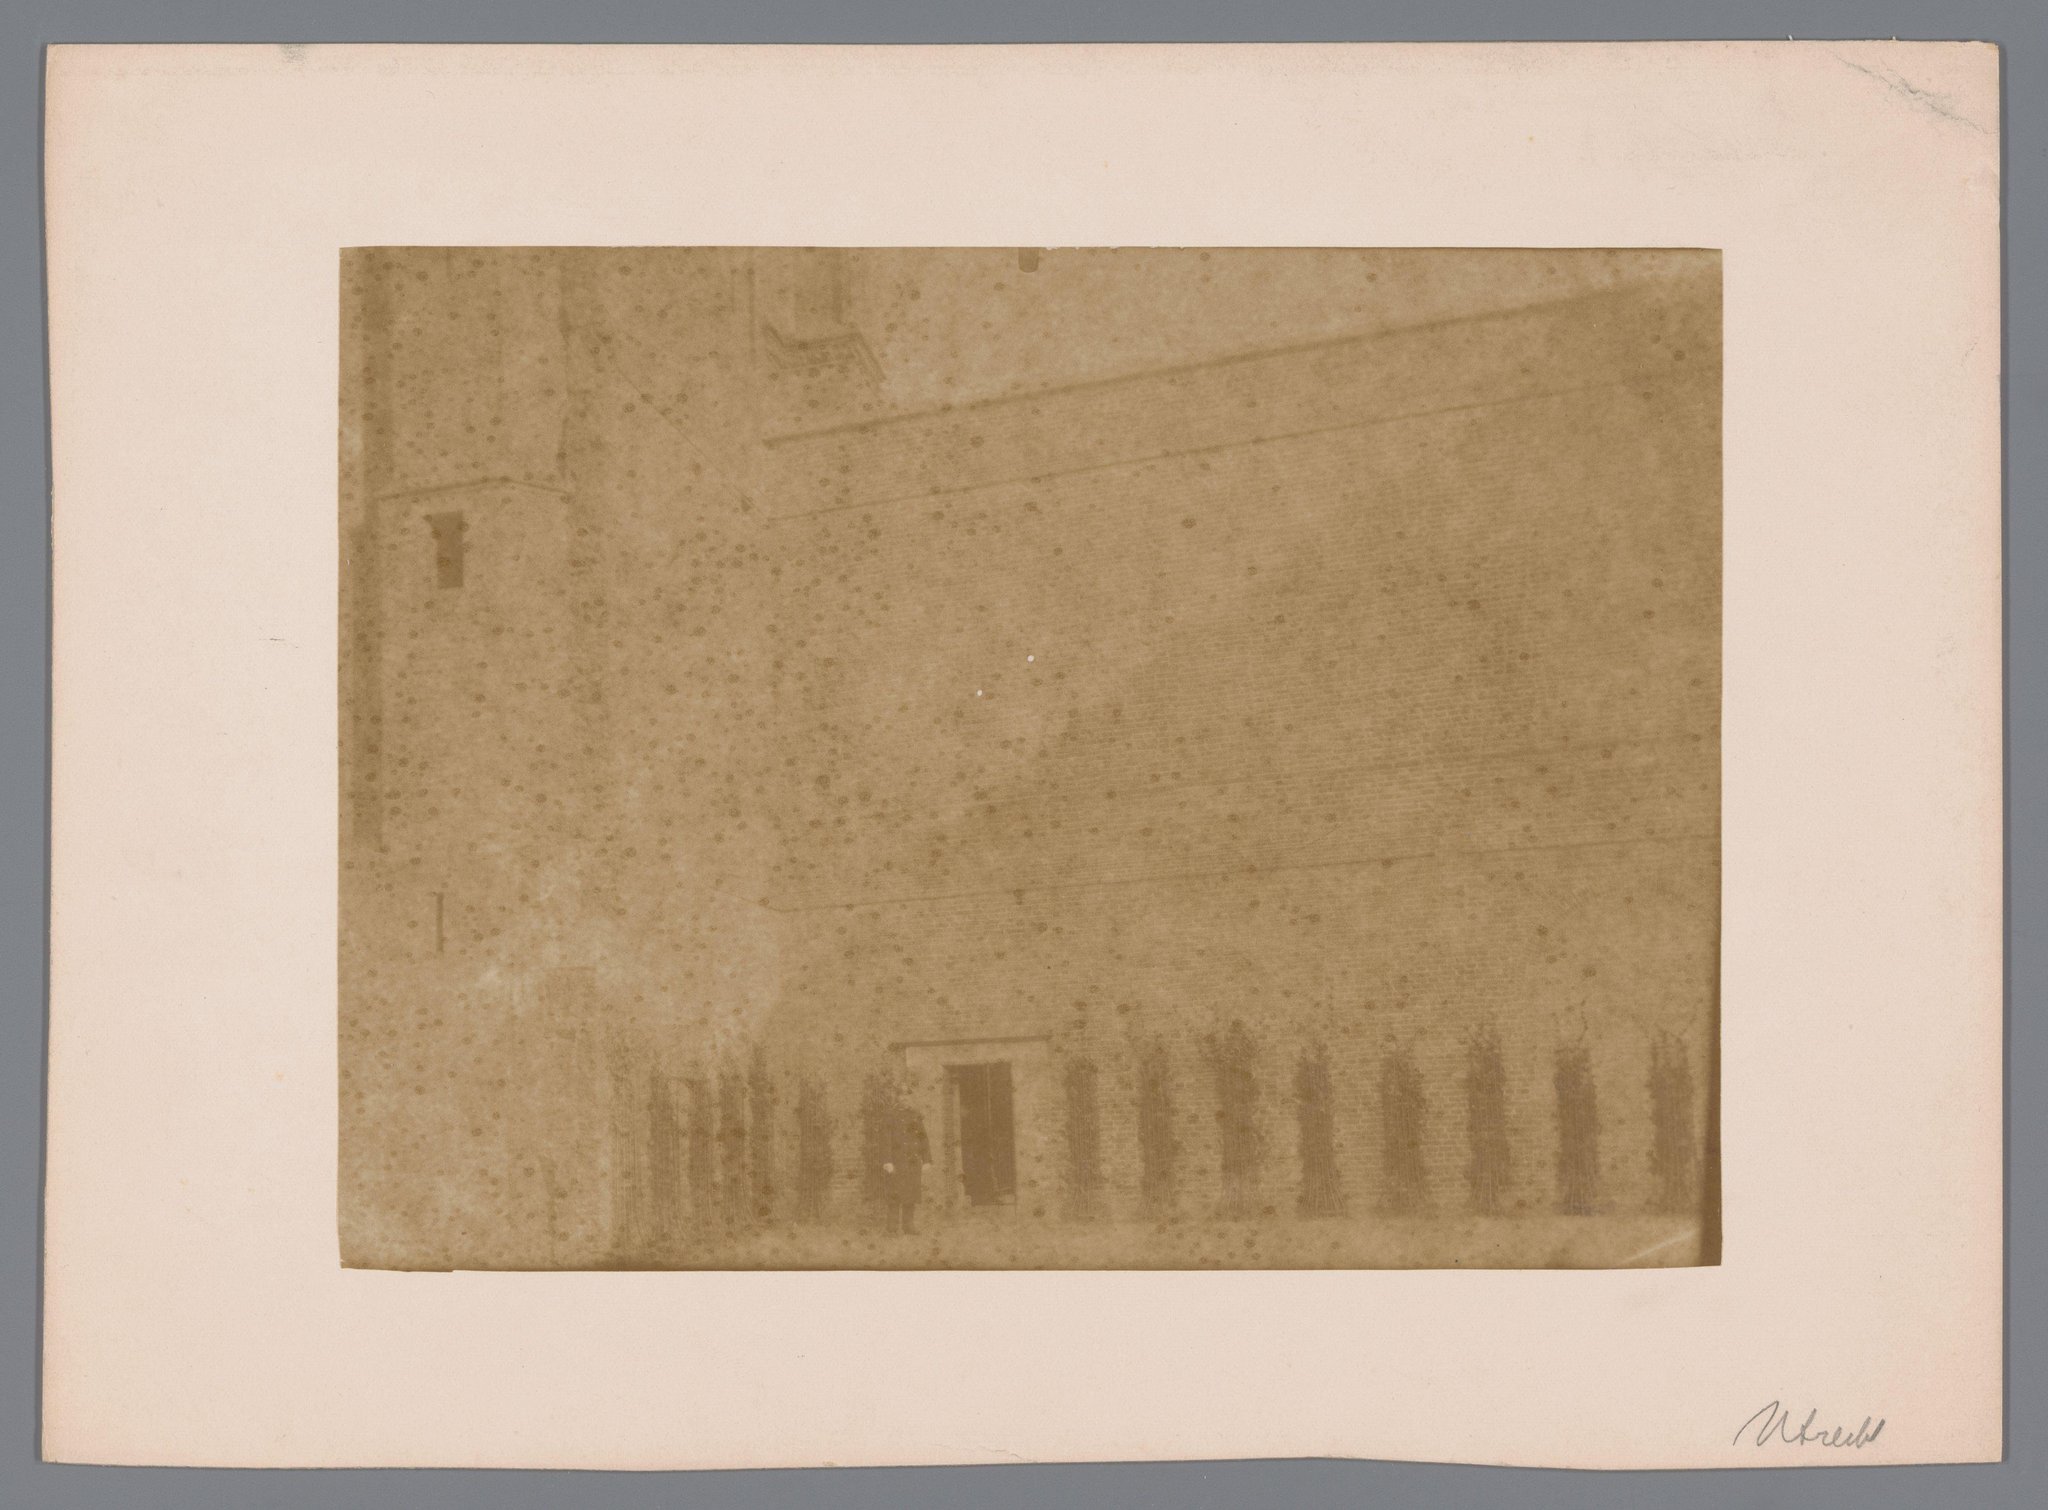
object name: photograph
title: Westmuur van het klooster bij de Dom van Utrecht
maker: anoniem (monumentenzorg)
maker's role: fotograaf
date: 1900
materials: cardboard, photographic support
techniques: albumen print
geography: utrecht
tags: cloisters ~ monastery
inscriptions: annotation: ‘Westmuur v/d kloostergang te Utrecht (Utrecht)/ dec 1900’, annotation: ‘Utrecht’